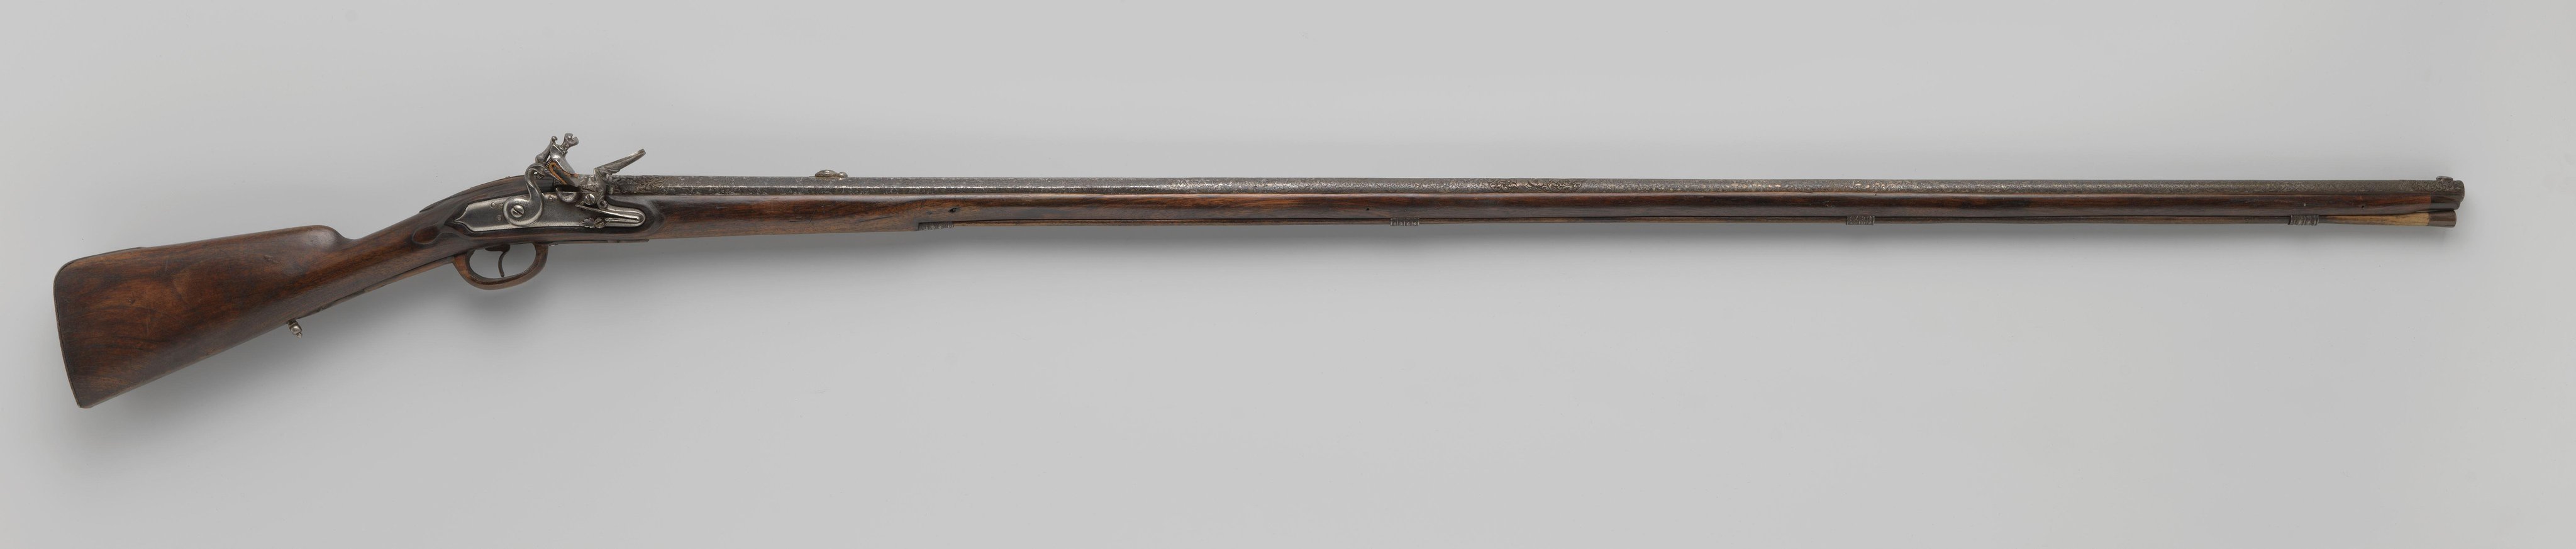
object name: flintlock pistol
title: Lang vuursteen jachtgeweer met 18-eeuwse lade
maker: Anonymous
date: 1655-1675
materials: horn, iron, silver, wood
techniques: encrustation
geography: sri lanka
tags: netherlands